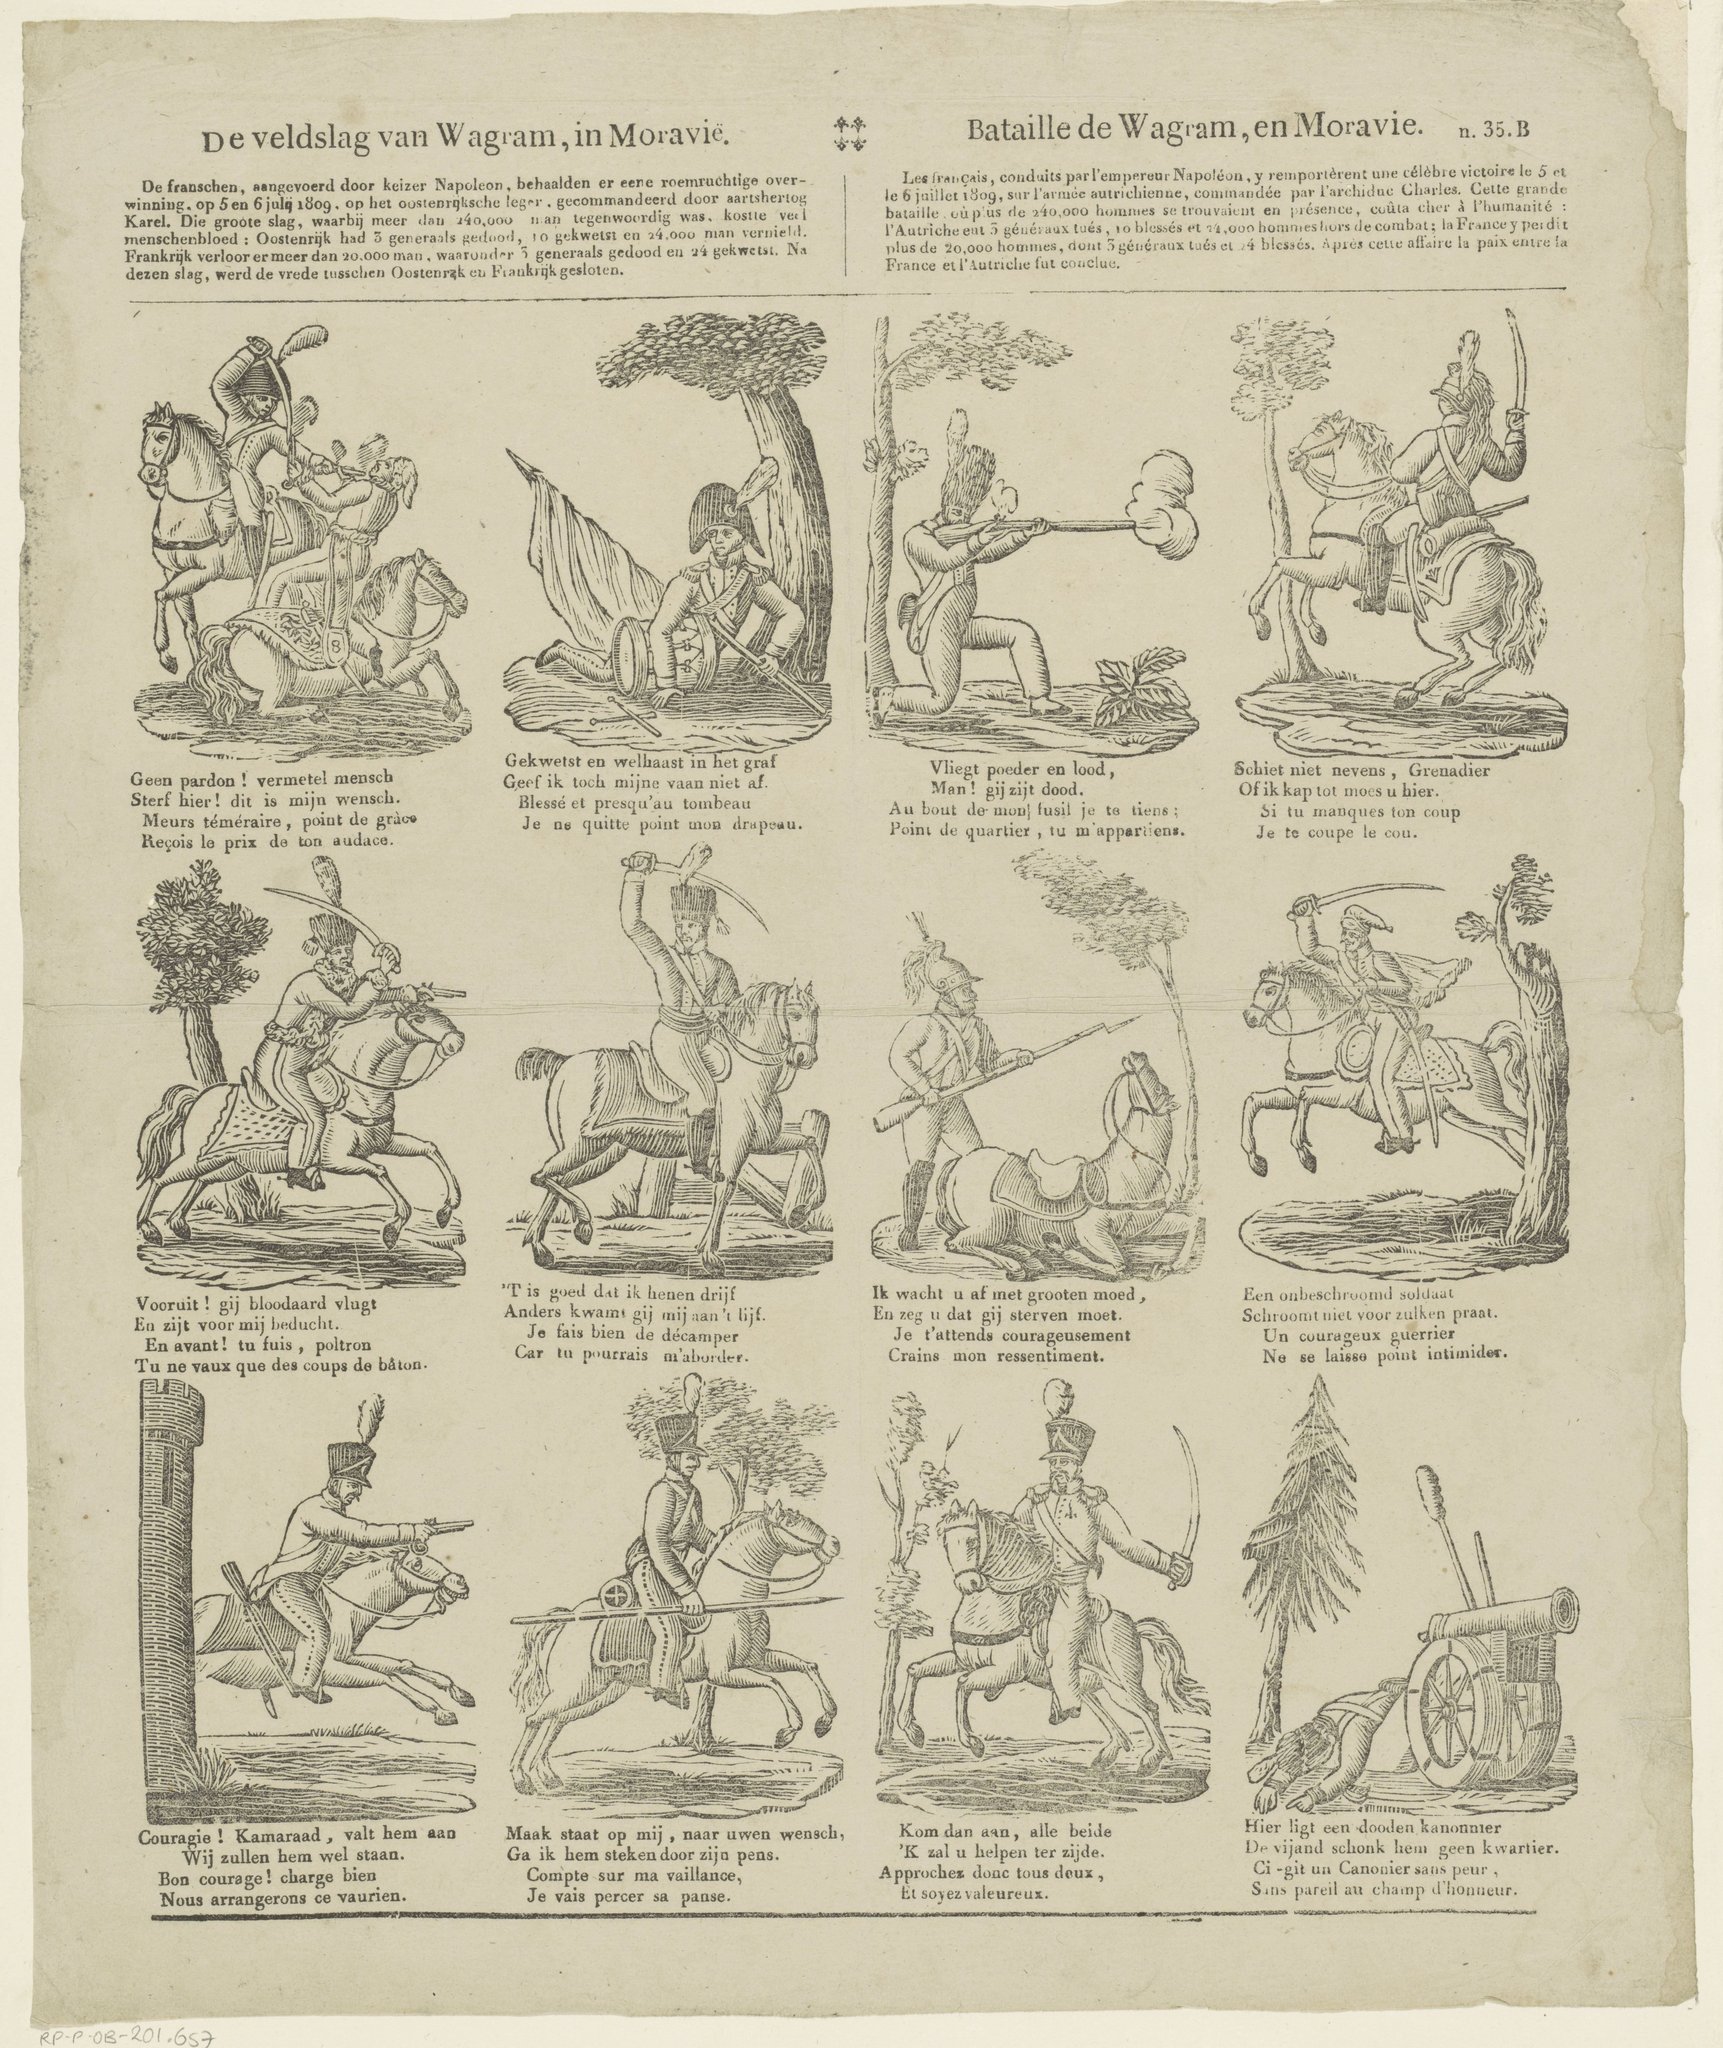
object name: popular print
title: De veldslag van Wagram, in Maravië / Bataille de Wagram, en Marovie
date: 1800-1833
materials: paper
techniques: letterpress printing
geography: turnhout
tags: warfare; military affairs (+ cavalry, horsemen), the soldier; the soldier's life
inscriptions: collector's mark: Lugt 2760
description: Blad met 12 voorstellingen van vechtende soldaten tijdens de Slag van Wagram. Onder elke afbeelding een tweeregelig vers in het Nederlands of in het Frans, een zesregelig bovenschrift in het Nederlands en in het Frans in twee kolommen. Genummerd rechtsboven: (n. 35. B).